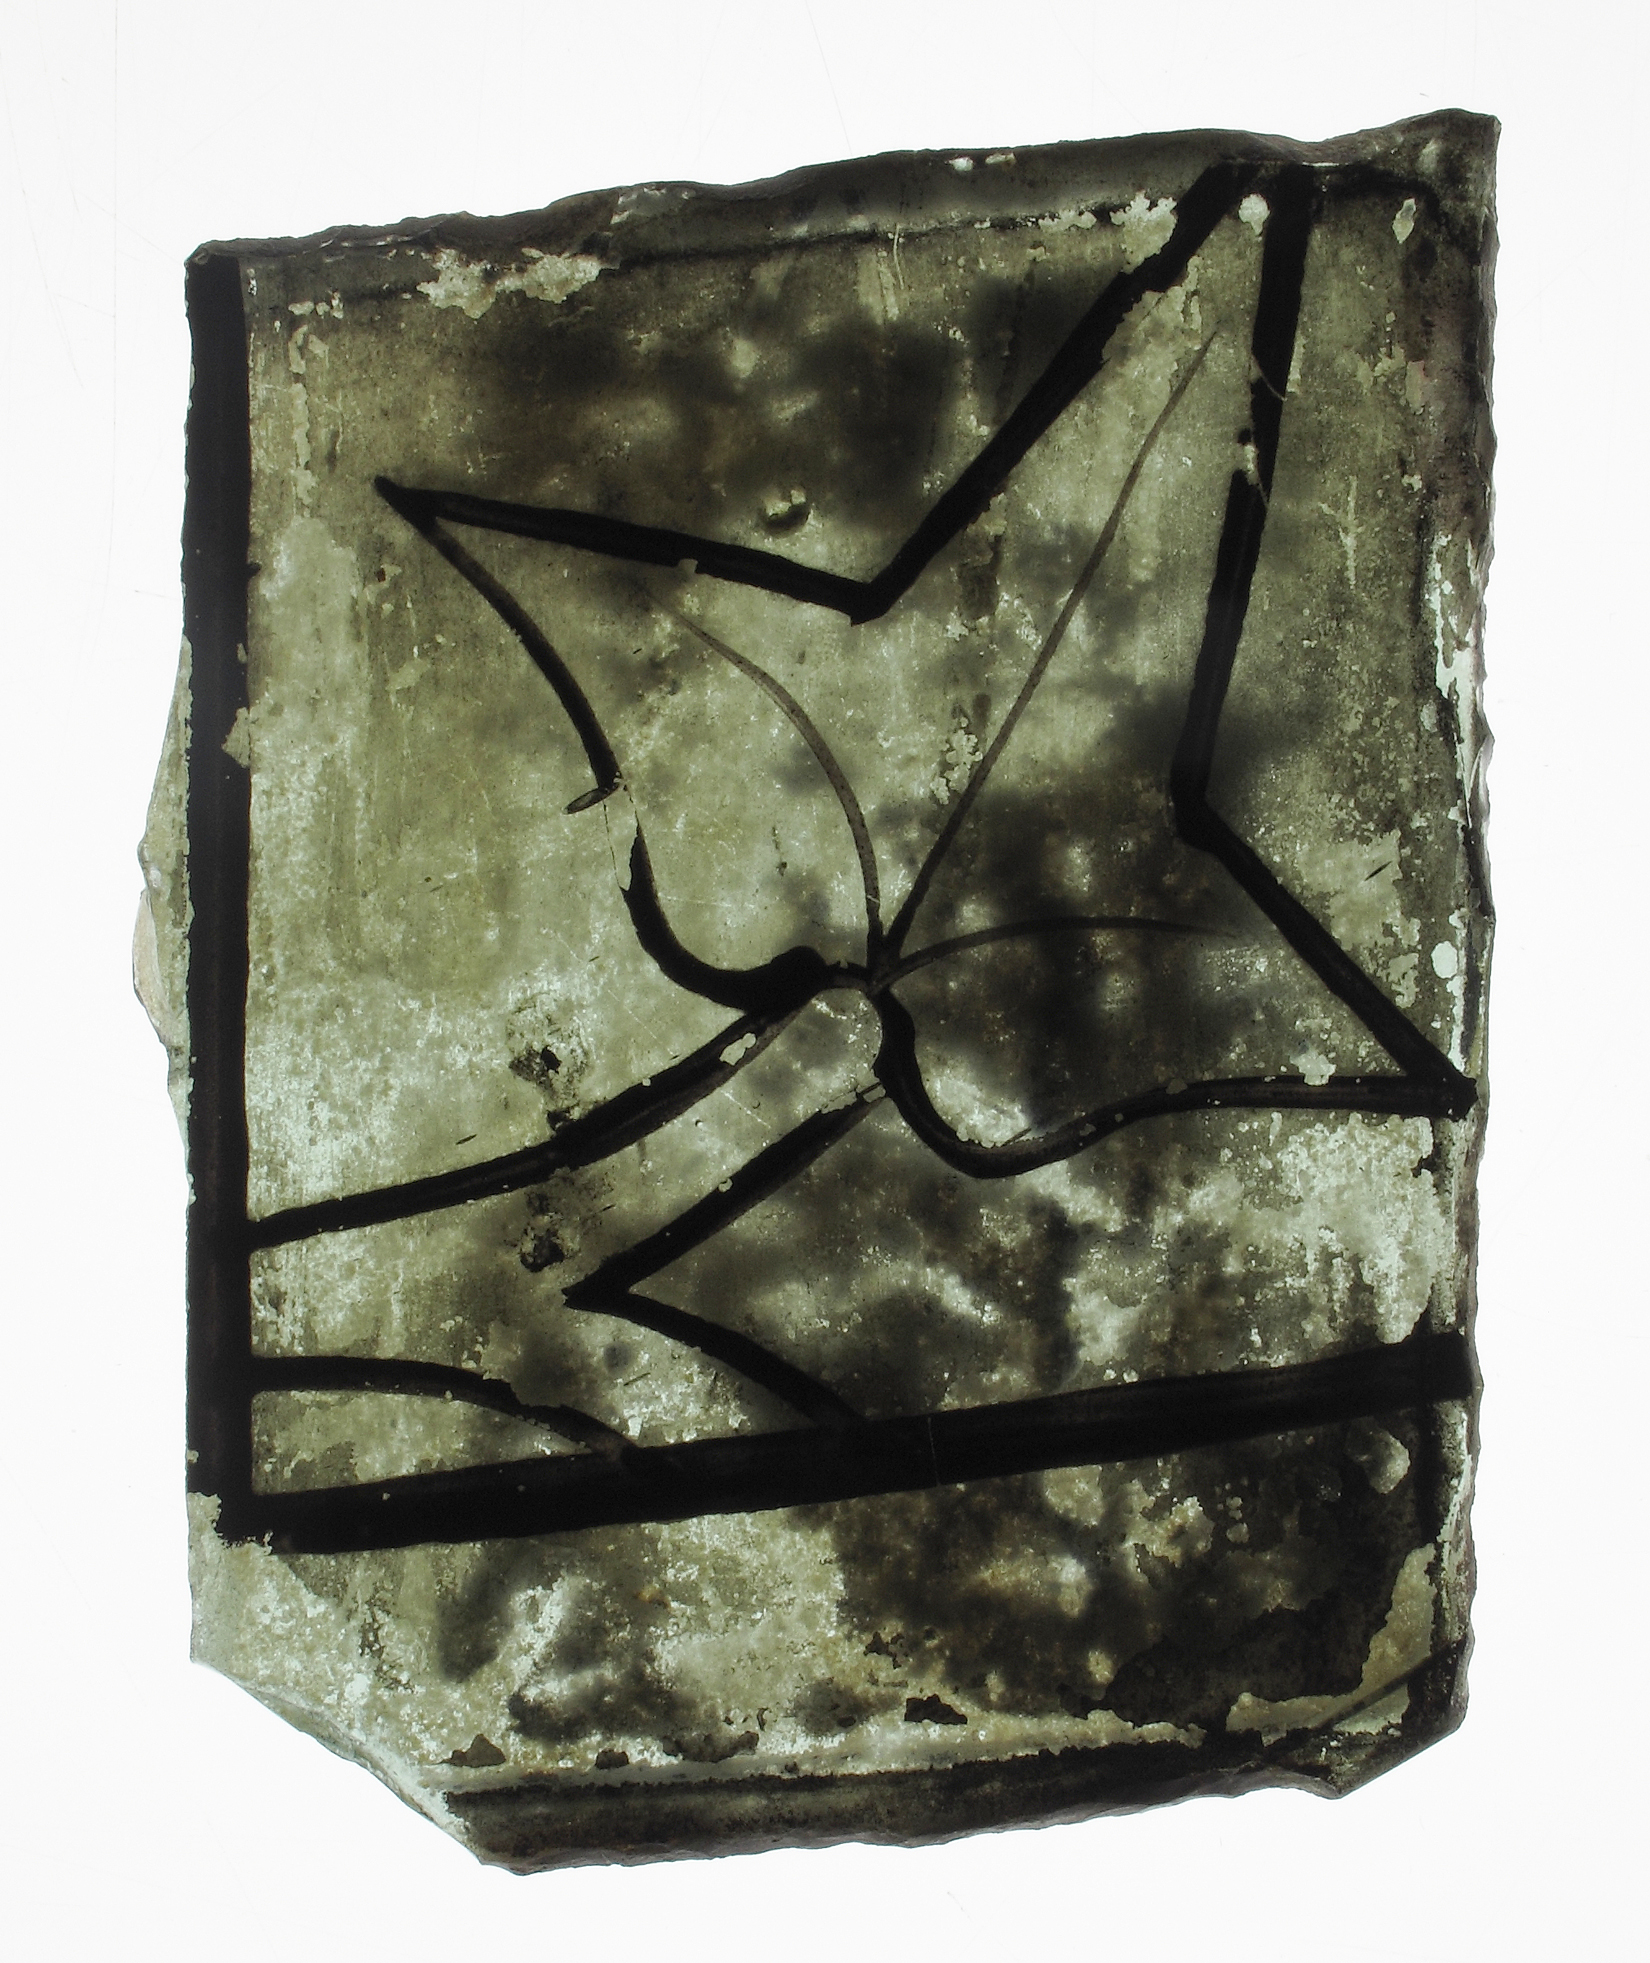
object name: fragment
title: Glass Fragment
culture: french or british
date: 1301-1333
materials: glass